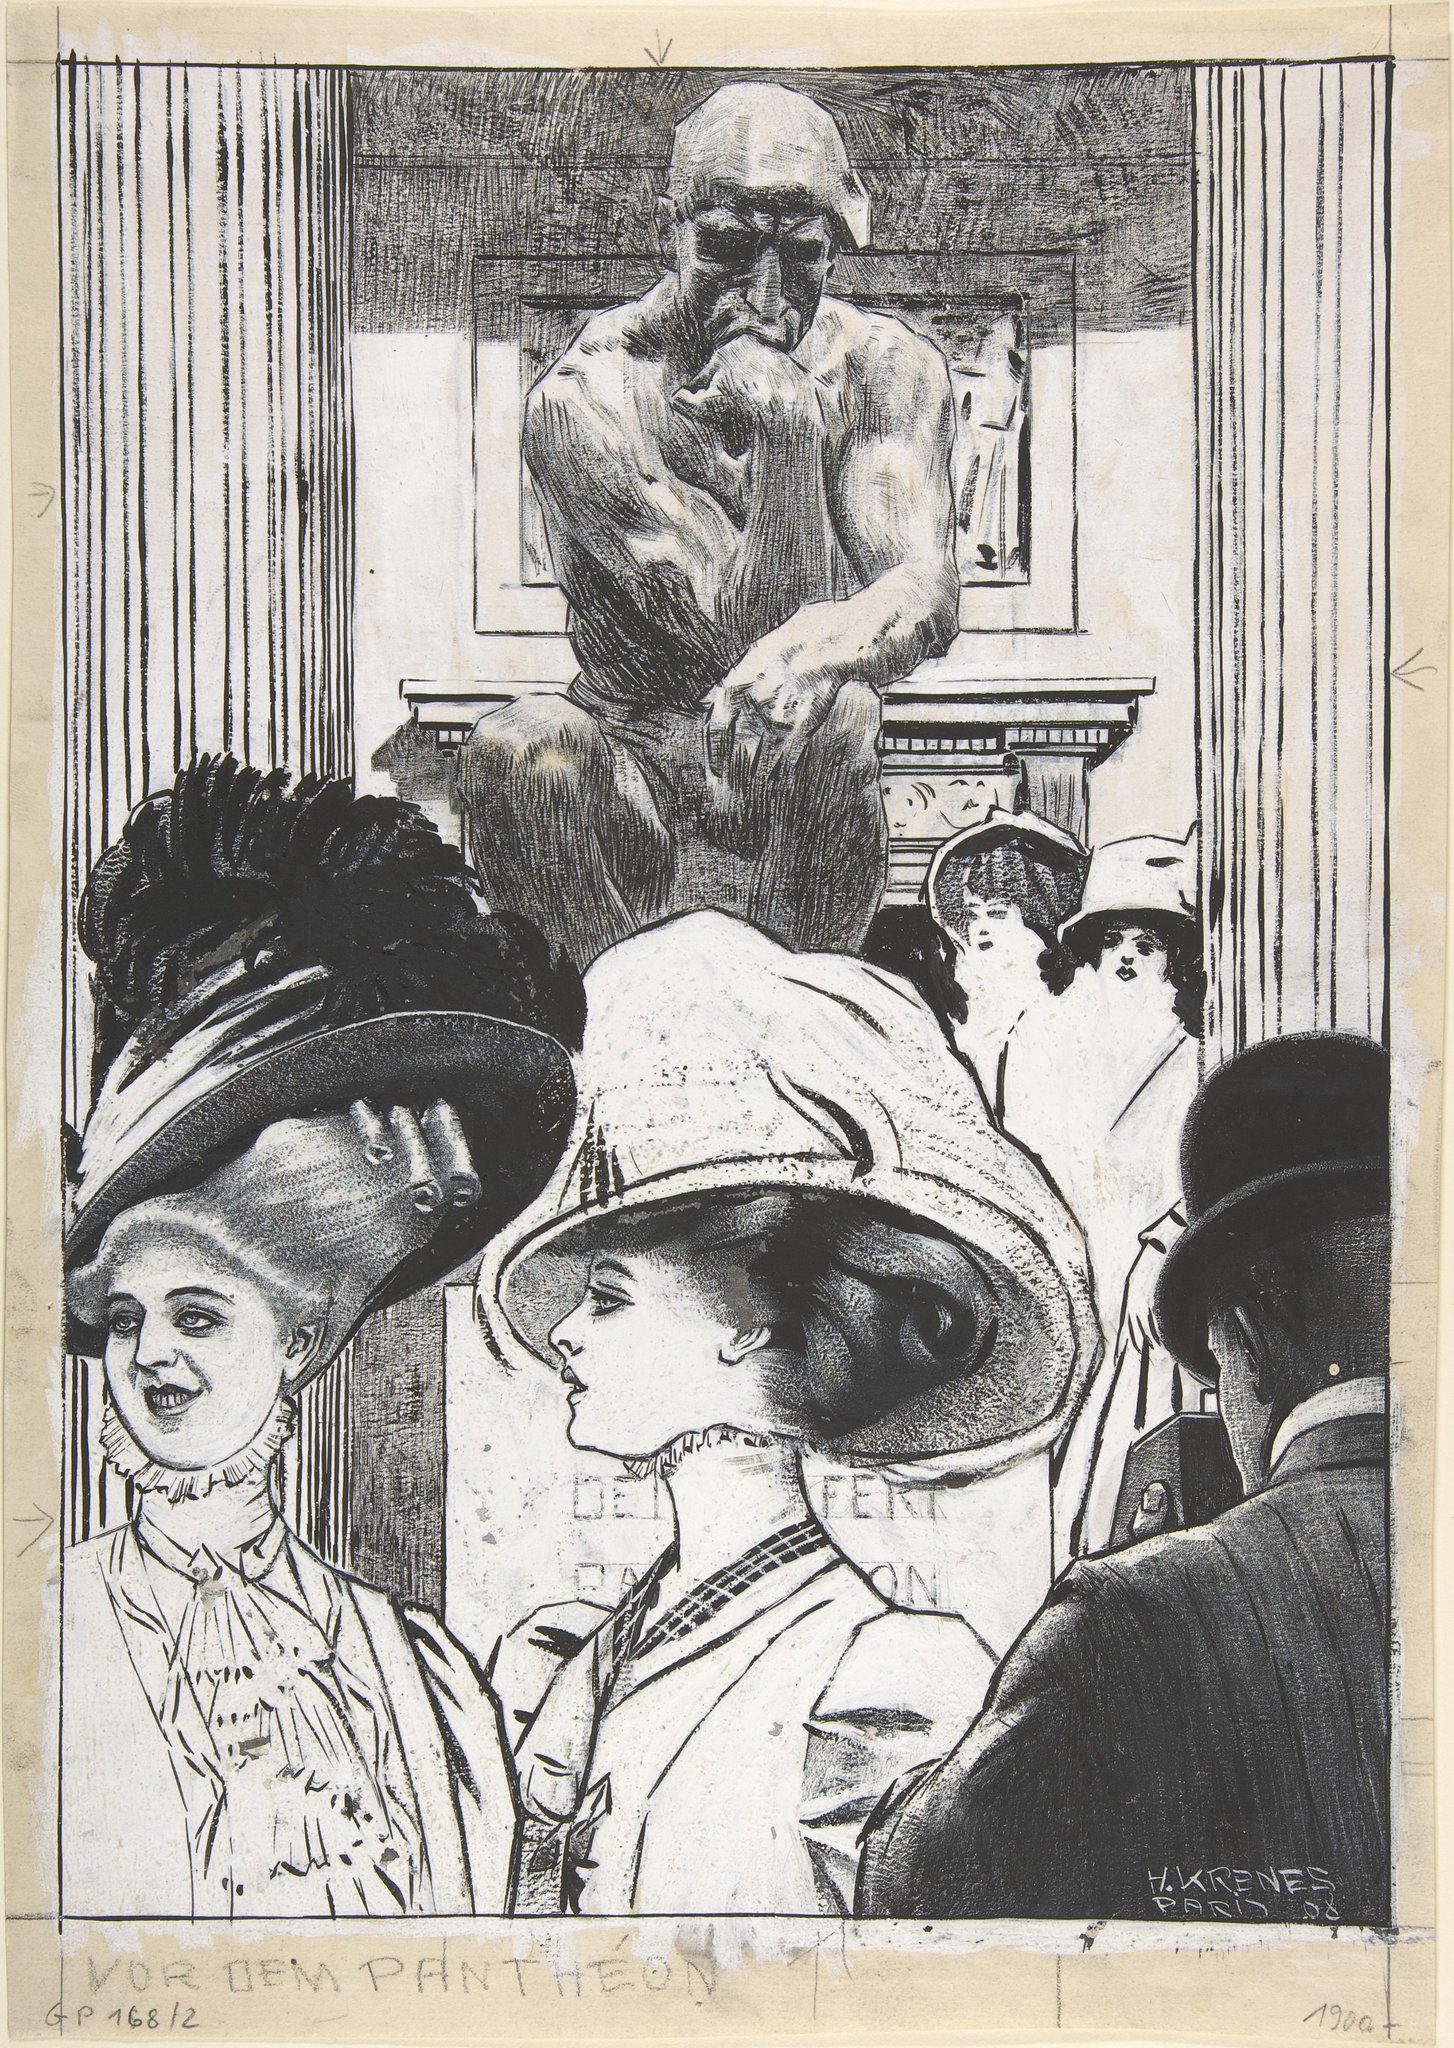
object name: drawing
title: Vor dem Pantheon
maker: heinrich krenes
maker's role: artist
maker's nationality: austrian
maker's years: 1874-1913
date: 1908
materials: gouache, graphite, ink, paint, silver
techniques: brush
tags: male nudes,women